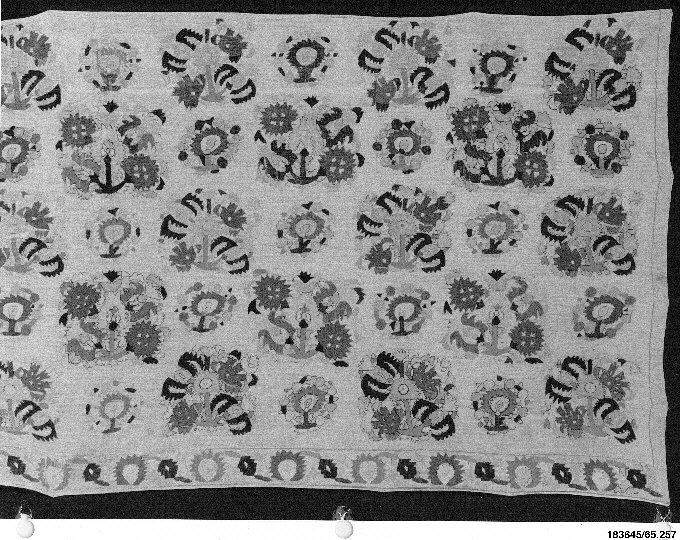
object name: hanging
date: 1701-1800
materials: linen, silk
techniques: embroidery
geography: morocco